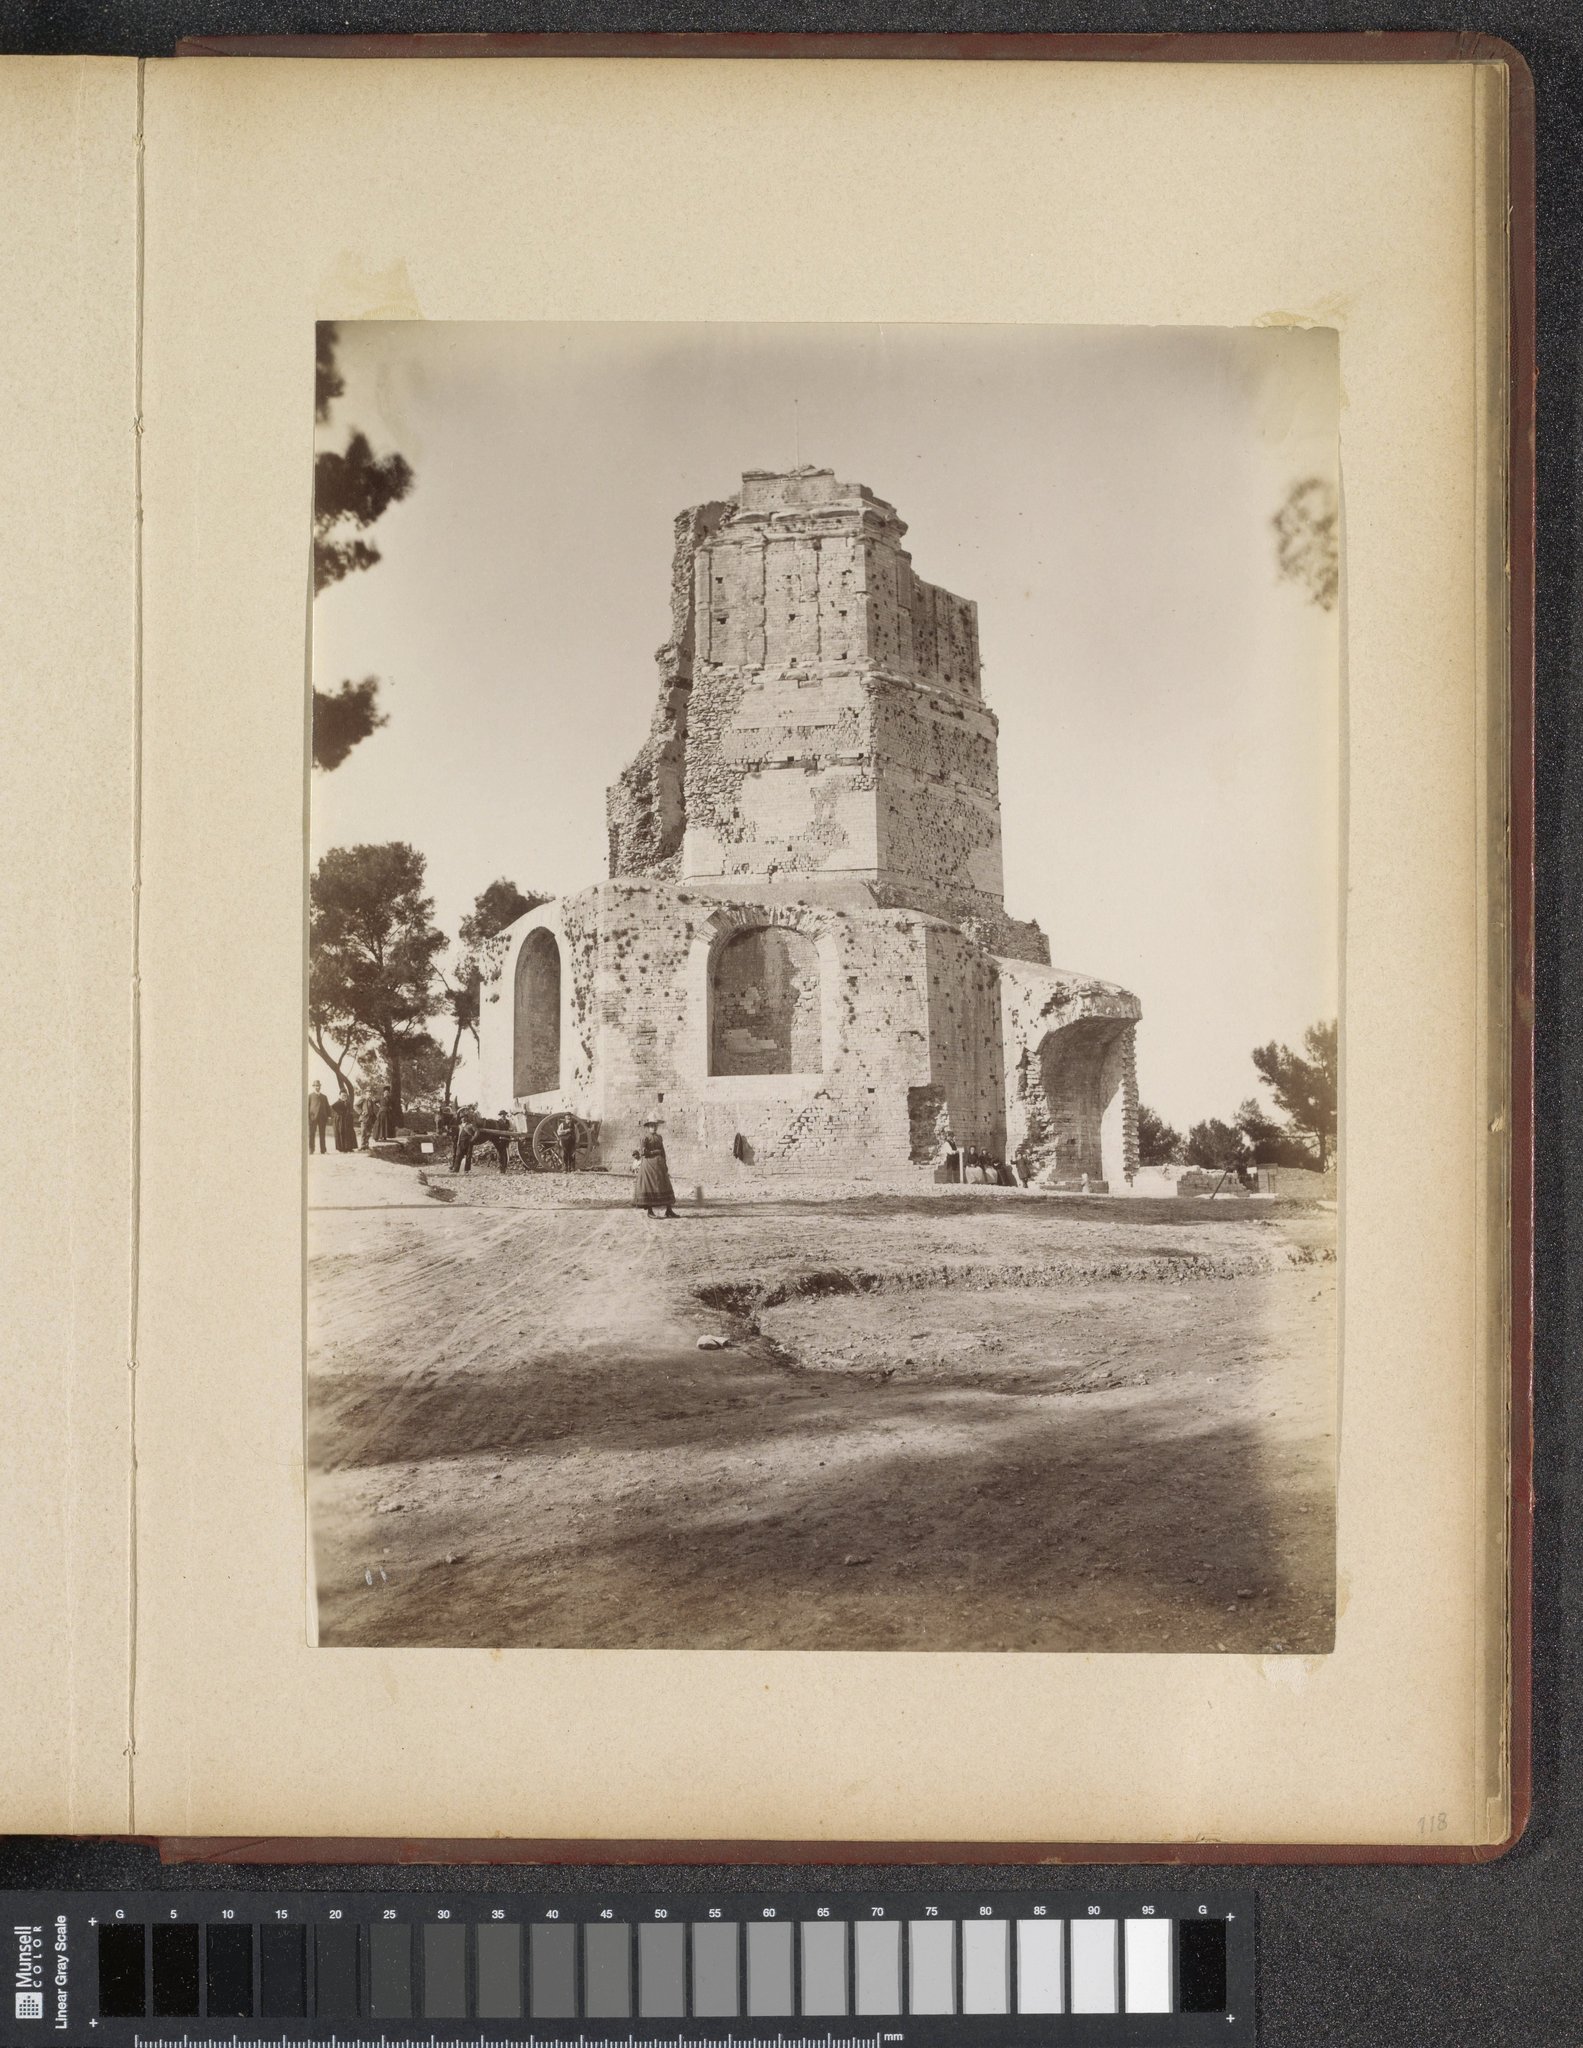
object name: album leaf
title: Exterieur van de Tour Magne in Nîmes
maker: Anonymous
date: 1870-1900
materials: paper, photographic support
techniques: albumen print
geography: nîmes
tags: towers ~ fortified city, ruin of a dwelling, house, castle, etc.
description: Onderdeel van Reisalbum met foto's van bezienswaardigheden in Italië en Zuid-Frankrijk.